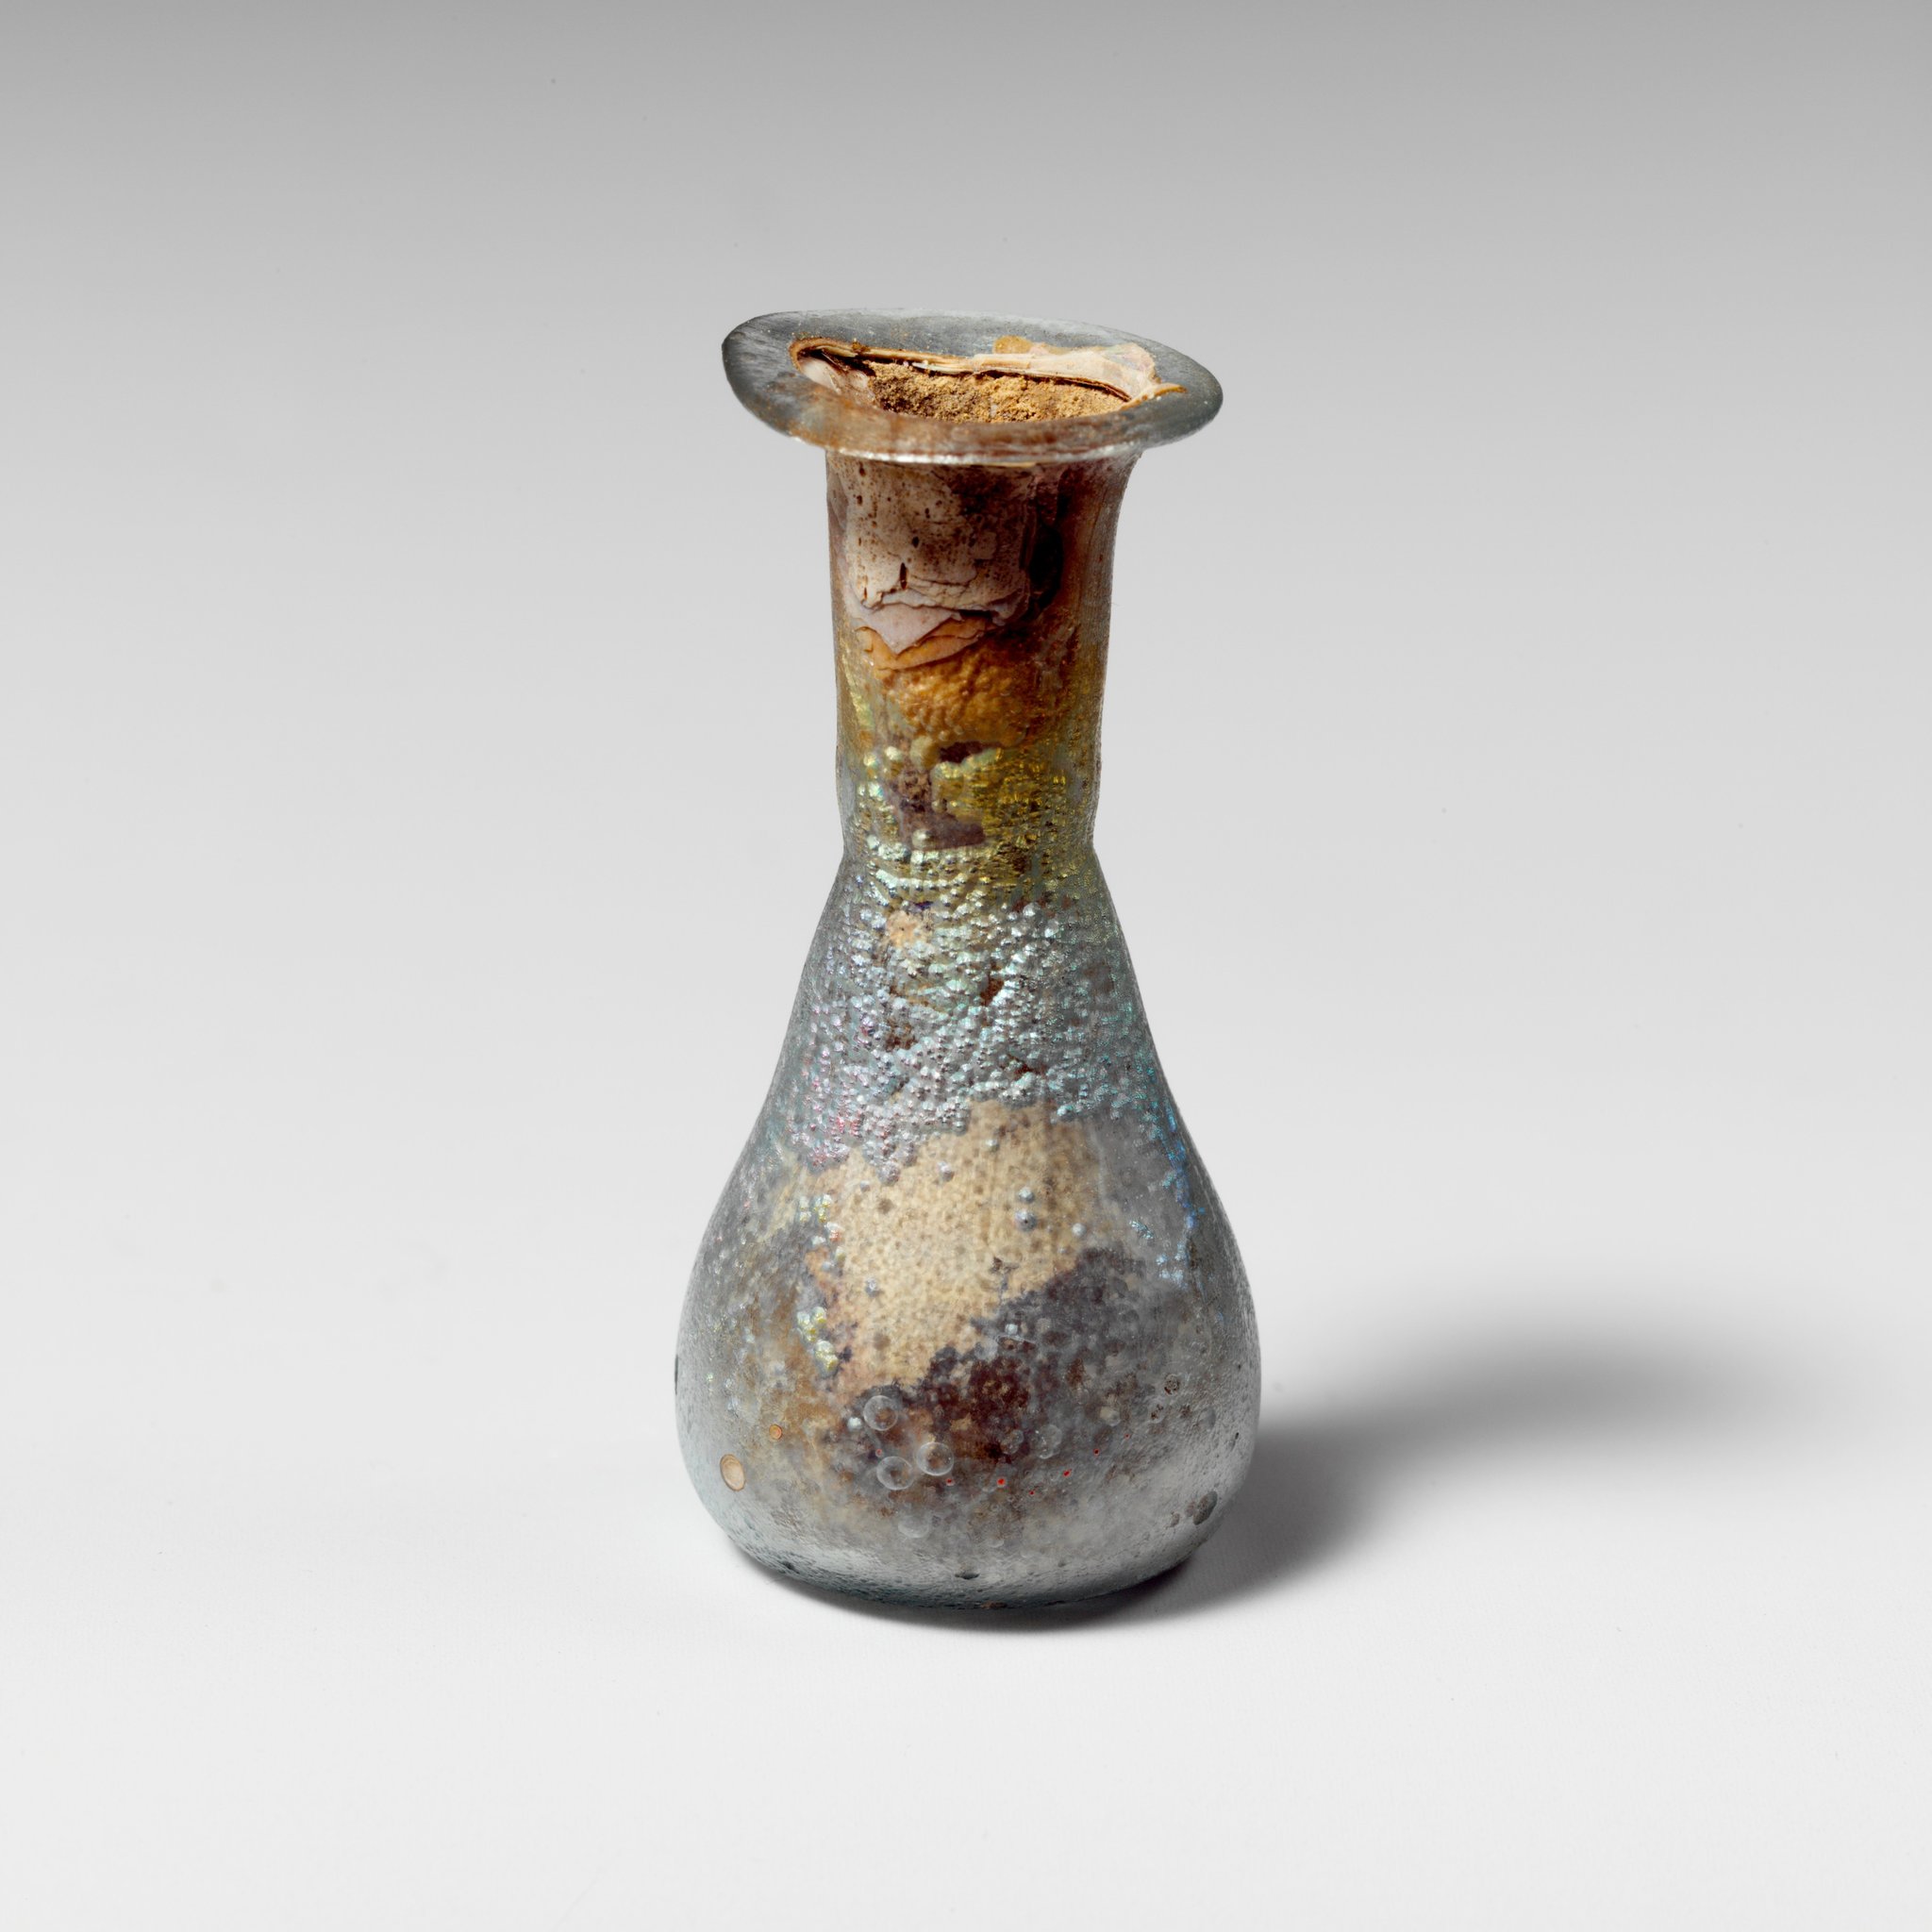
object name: perfume bottle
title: Glass perfume bottle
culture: roman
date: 1-100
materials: glass